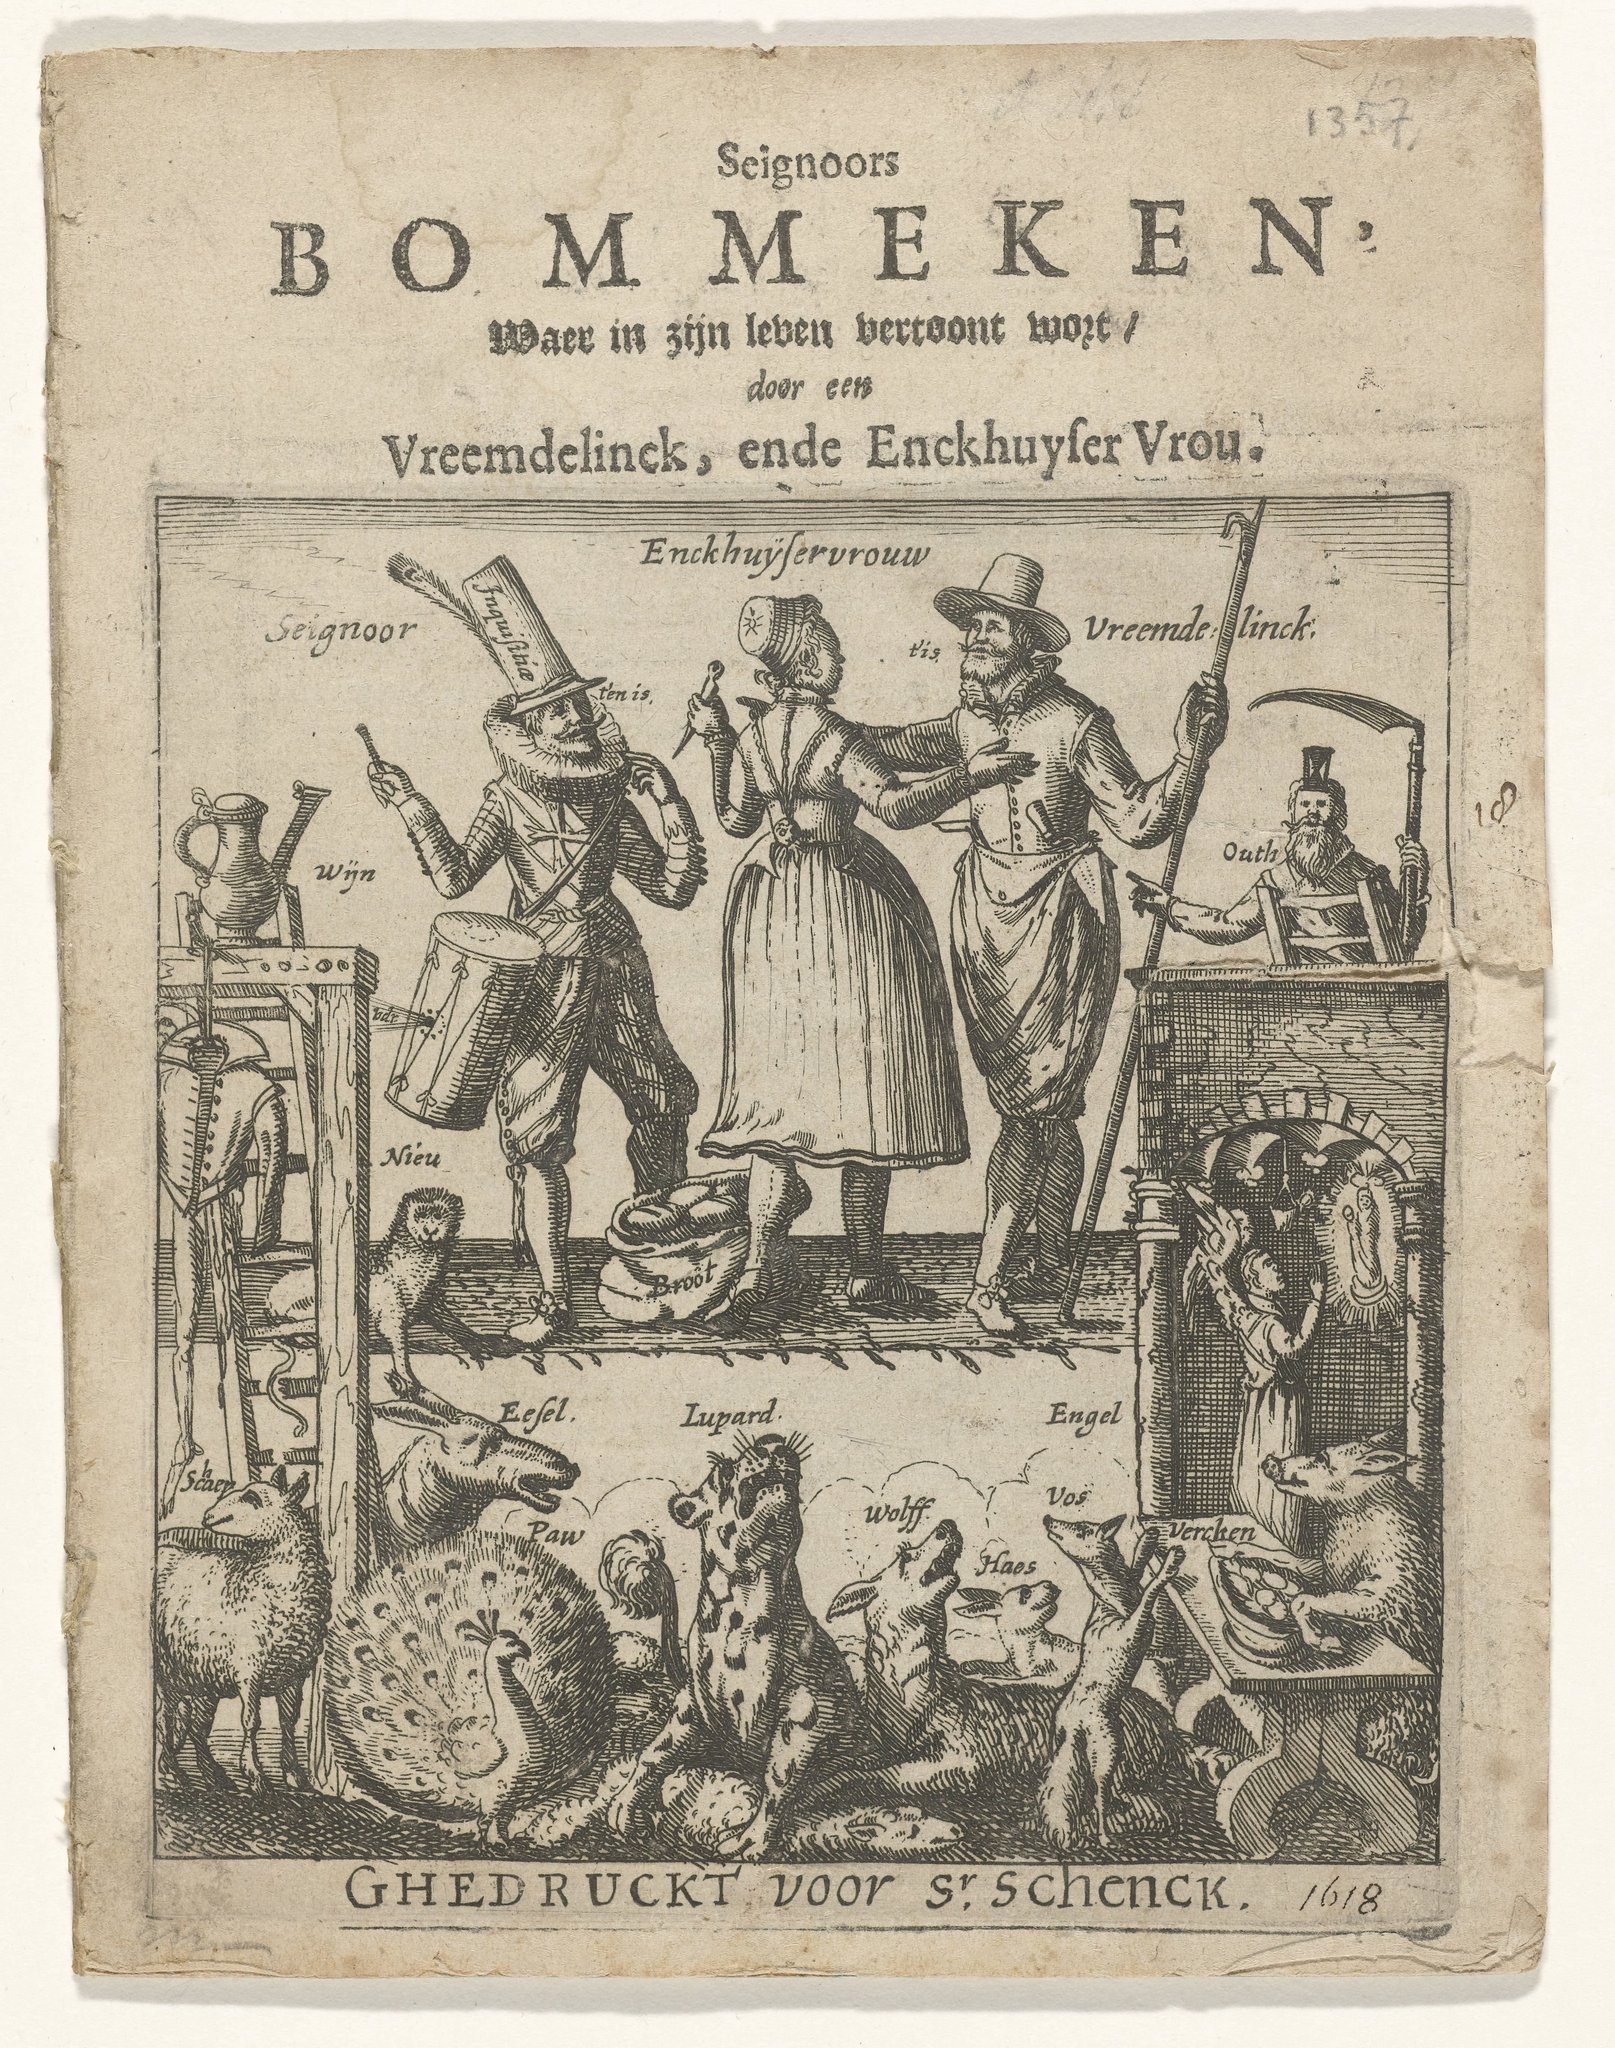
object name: print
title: Titelpagina van het pamflet: Seignoors bommeken, waer in zijn leven vertoont wort, door een vreemdelinck, ende Enckhuyser vrou, 1618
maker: Anonymous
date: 1618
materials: paper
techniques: etching, letterpress printing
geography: northern netherlands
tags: dancing, enkhuizen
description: Titelblad van het pamflet: Seignoors bommeken, waer in zijn leven vertoont wort, door een vreemdelinck, ende Enckhuyser vrou, 1618. Een Enkhuizer vrouw dansend met een vreemdeling op de muziek van een Spanjaard (Seignoor) met een trommel. Op de voorgrond allerlei verschillende dieren die de eigenschappen van de Spanjaard verbeelden. Titelblad van een pamflet van 16 bladzijden tegen Spanje en de remonstranten.